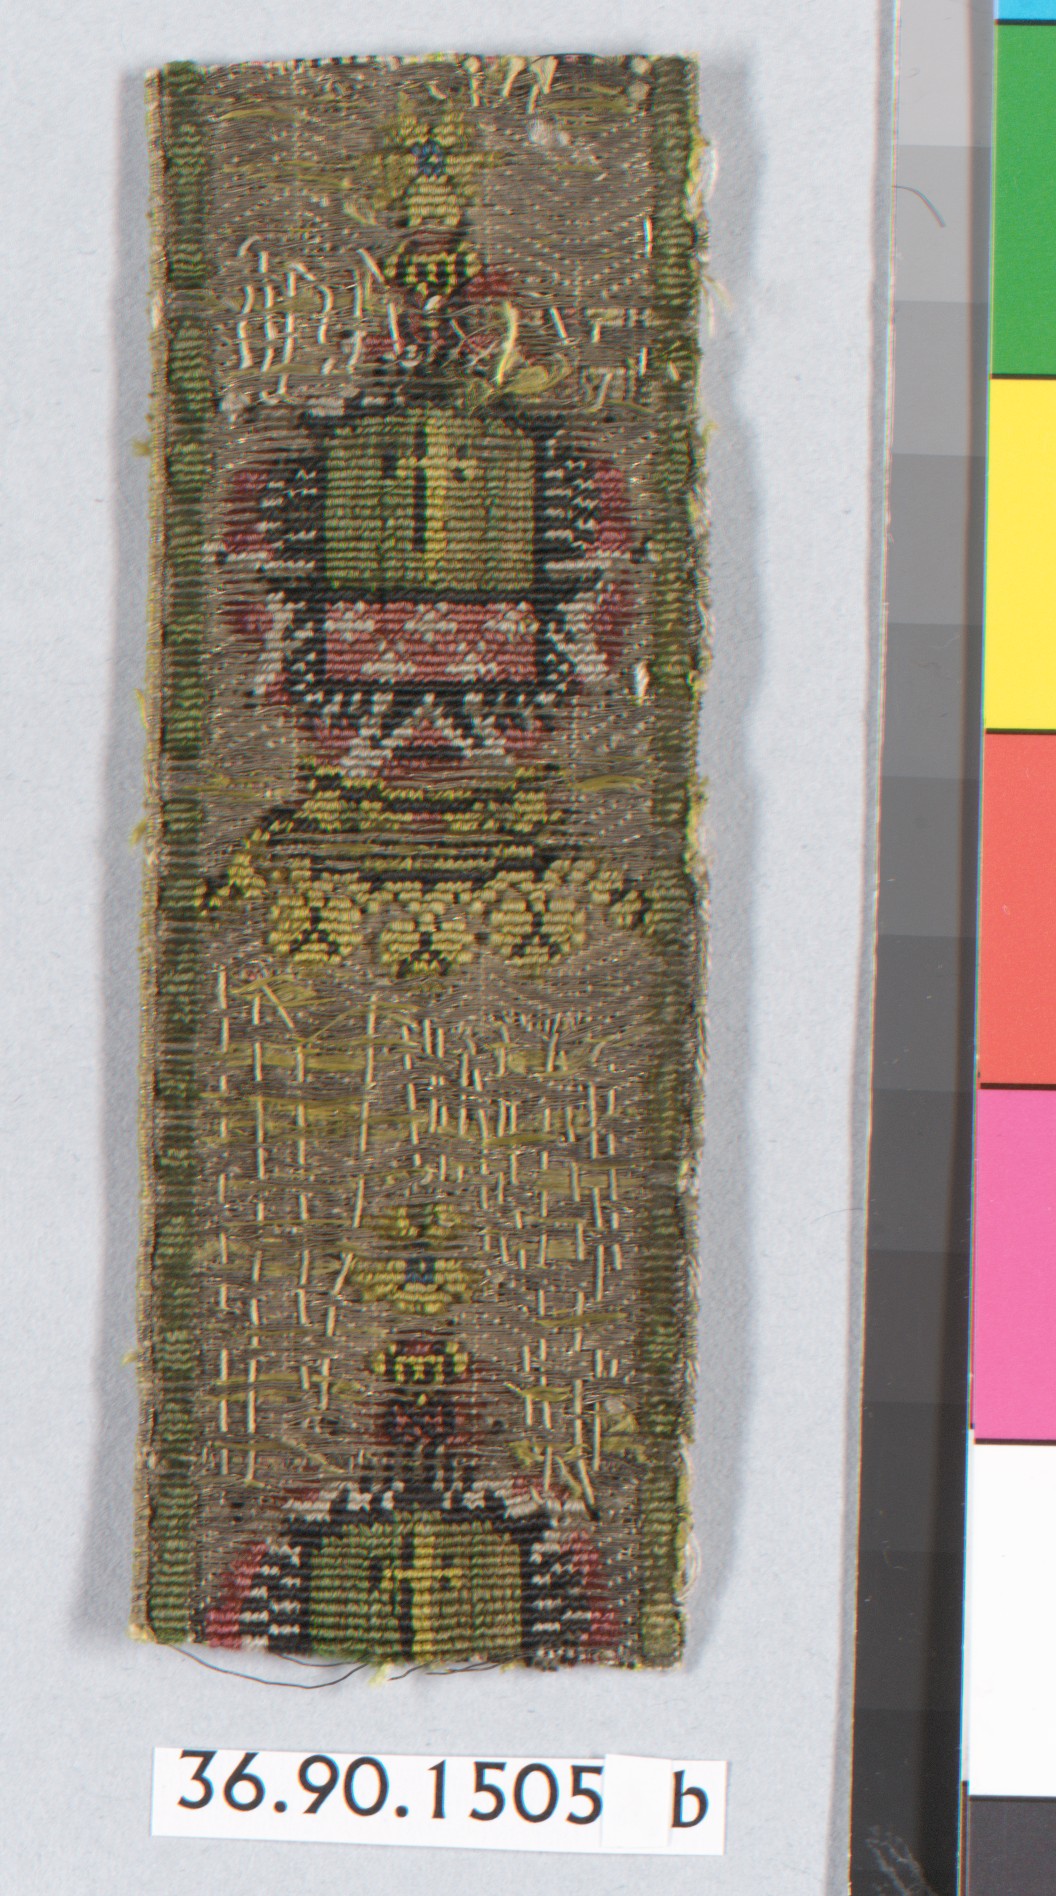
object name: piece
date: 1701-1900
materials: silk